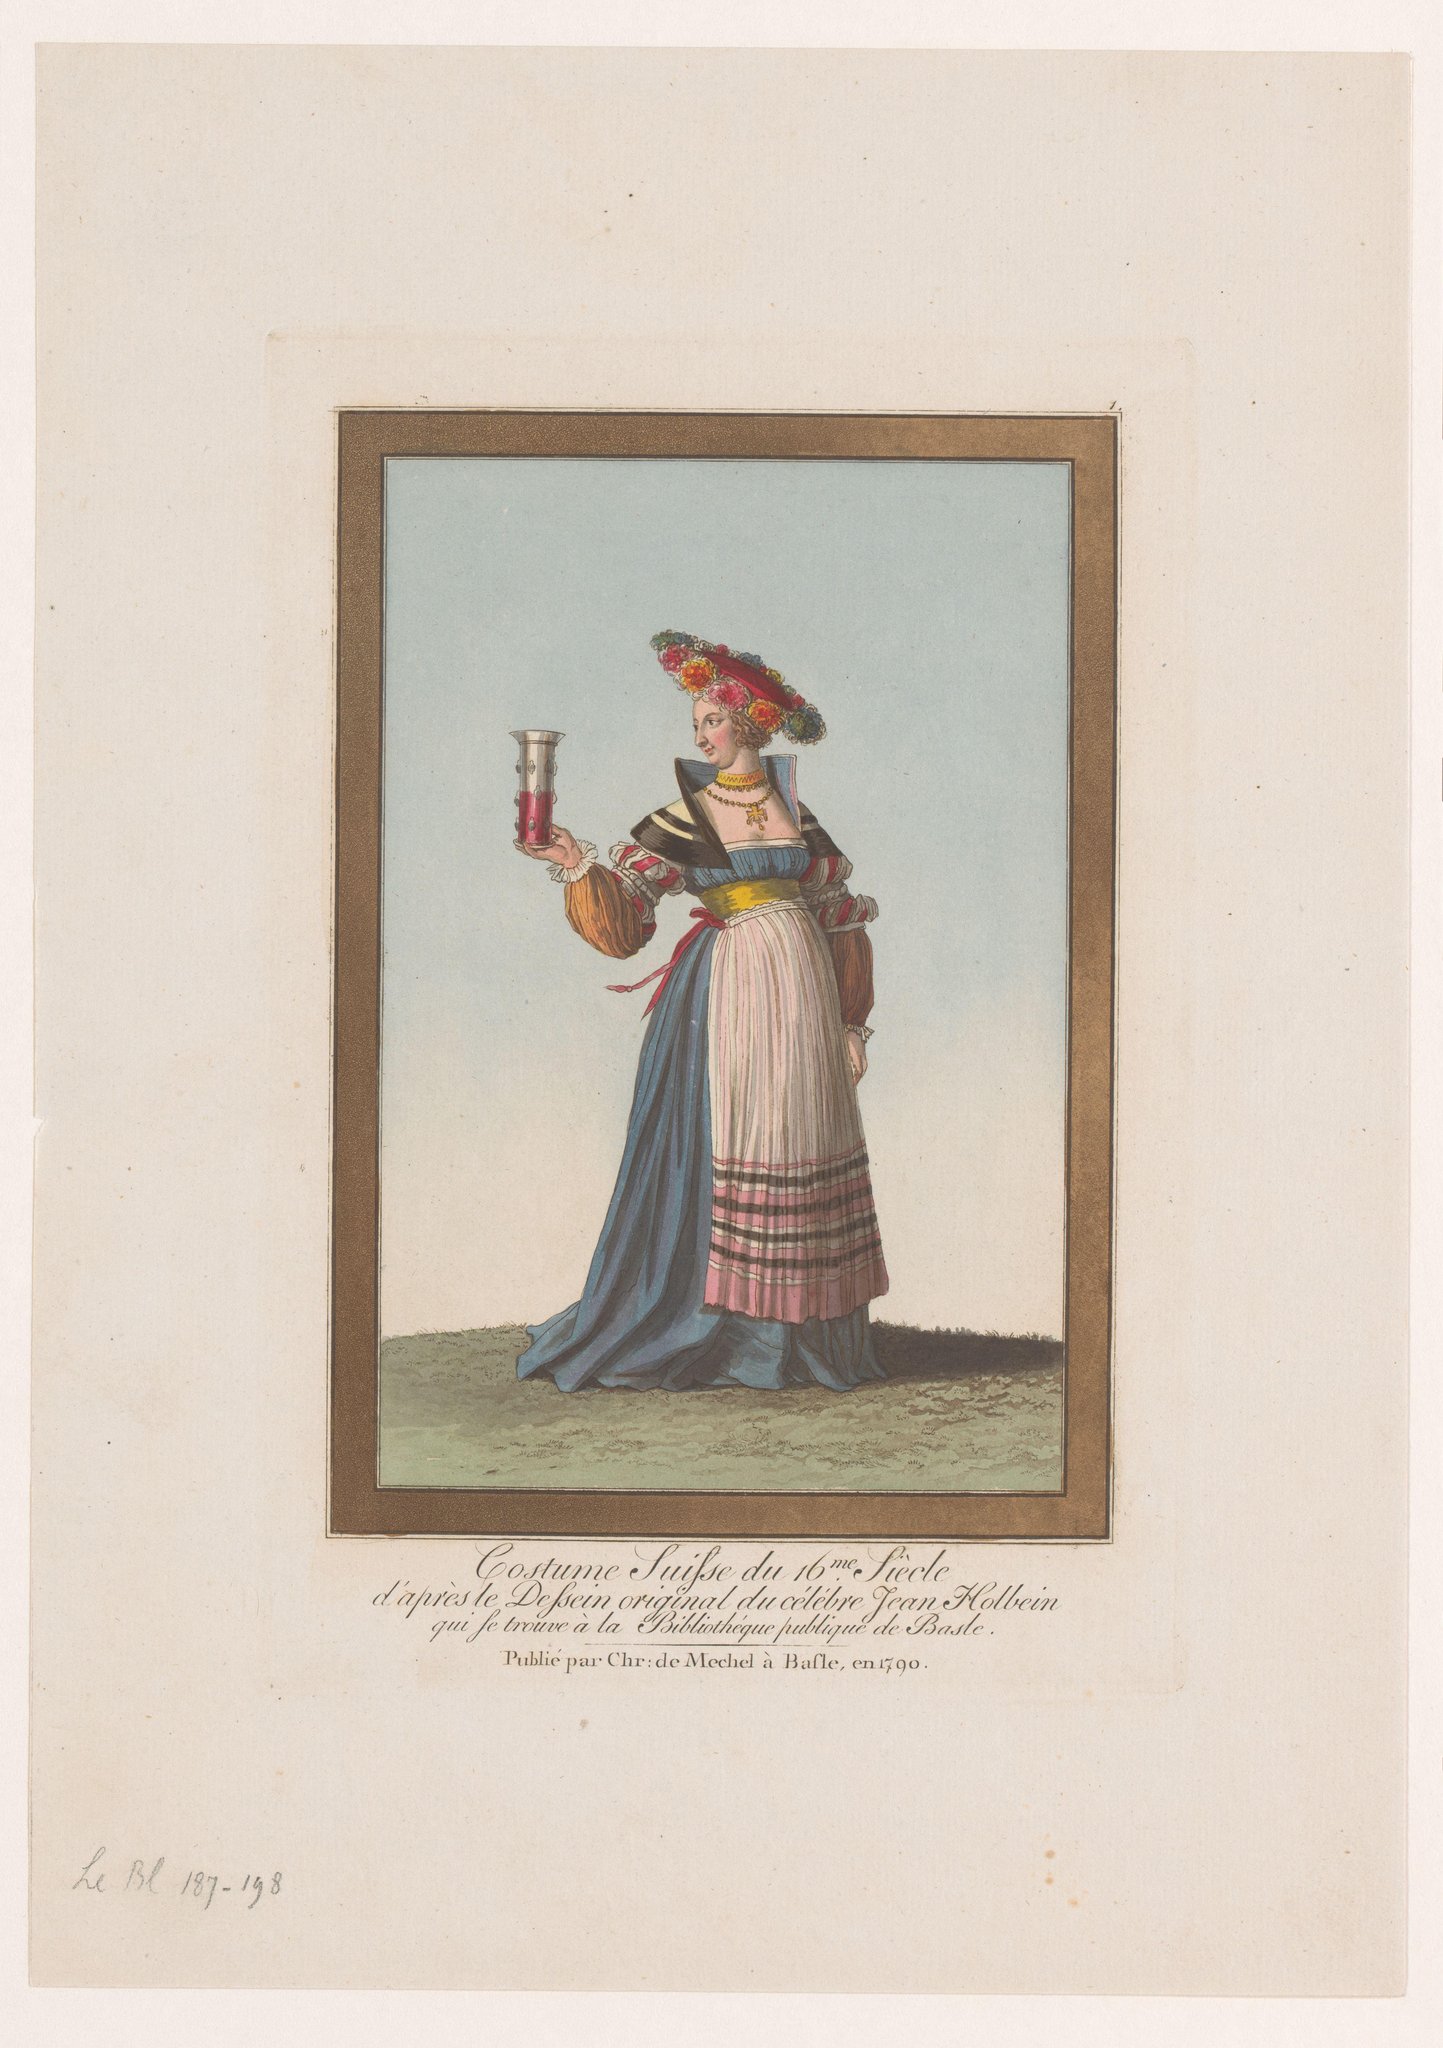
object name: print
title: Costume Suisse du 16me siècle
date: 1790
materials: paper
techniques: aquatint, etching, hand coloring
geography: basel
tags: dress, gown: court gown or court dress, mug, beaker, goblet, clothes, costume, switzerland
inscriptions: collector's mark: Lugt 2228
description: De serie behoort tot de 4-delige publicatie 'Oeuvre de Jean Holbein', Bazel 1780-1795, door Christian von Mechel.